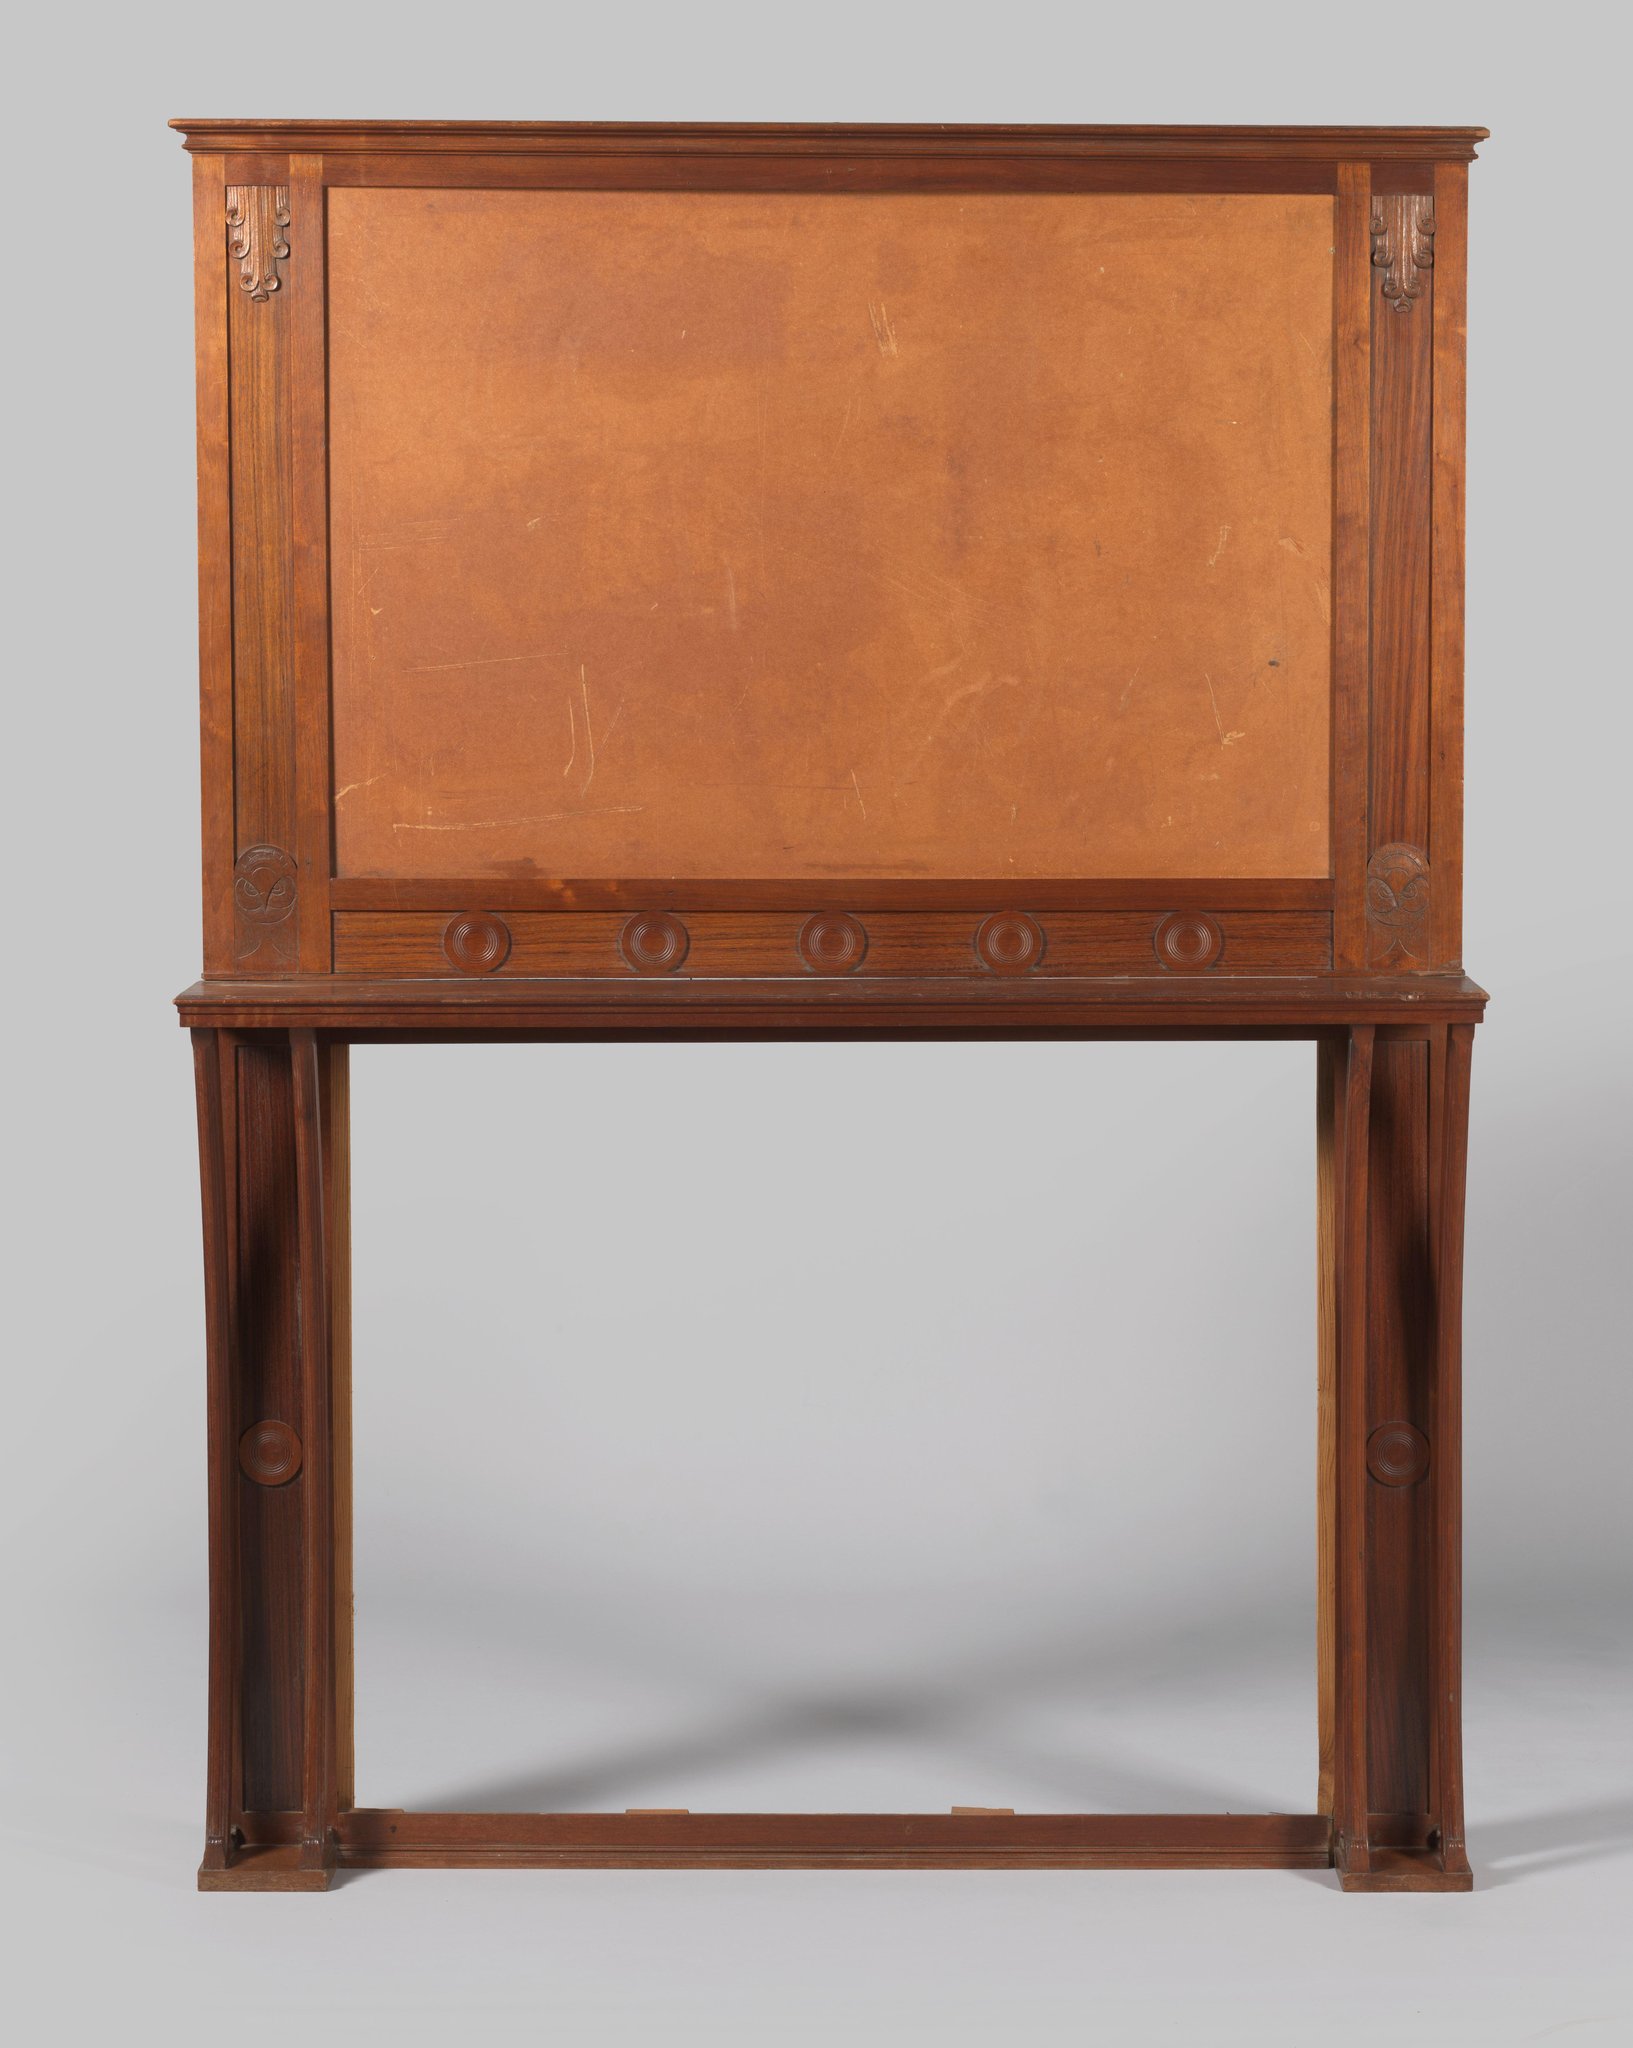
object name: interieuronderdeel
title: Haardombouw, onderdeel van een betimmering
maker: napoleon le grand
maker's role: furniture worker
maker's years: 1857-1932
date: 1900-1905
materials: wood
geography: netherlands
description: Haardombouw, onderdeel van een betimmering, uitgevoerd in noten, grenen en palissander.